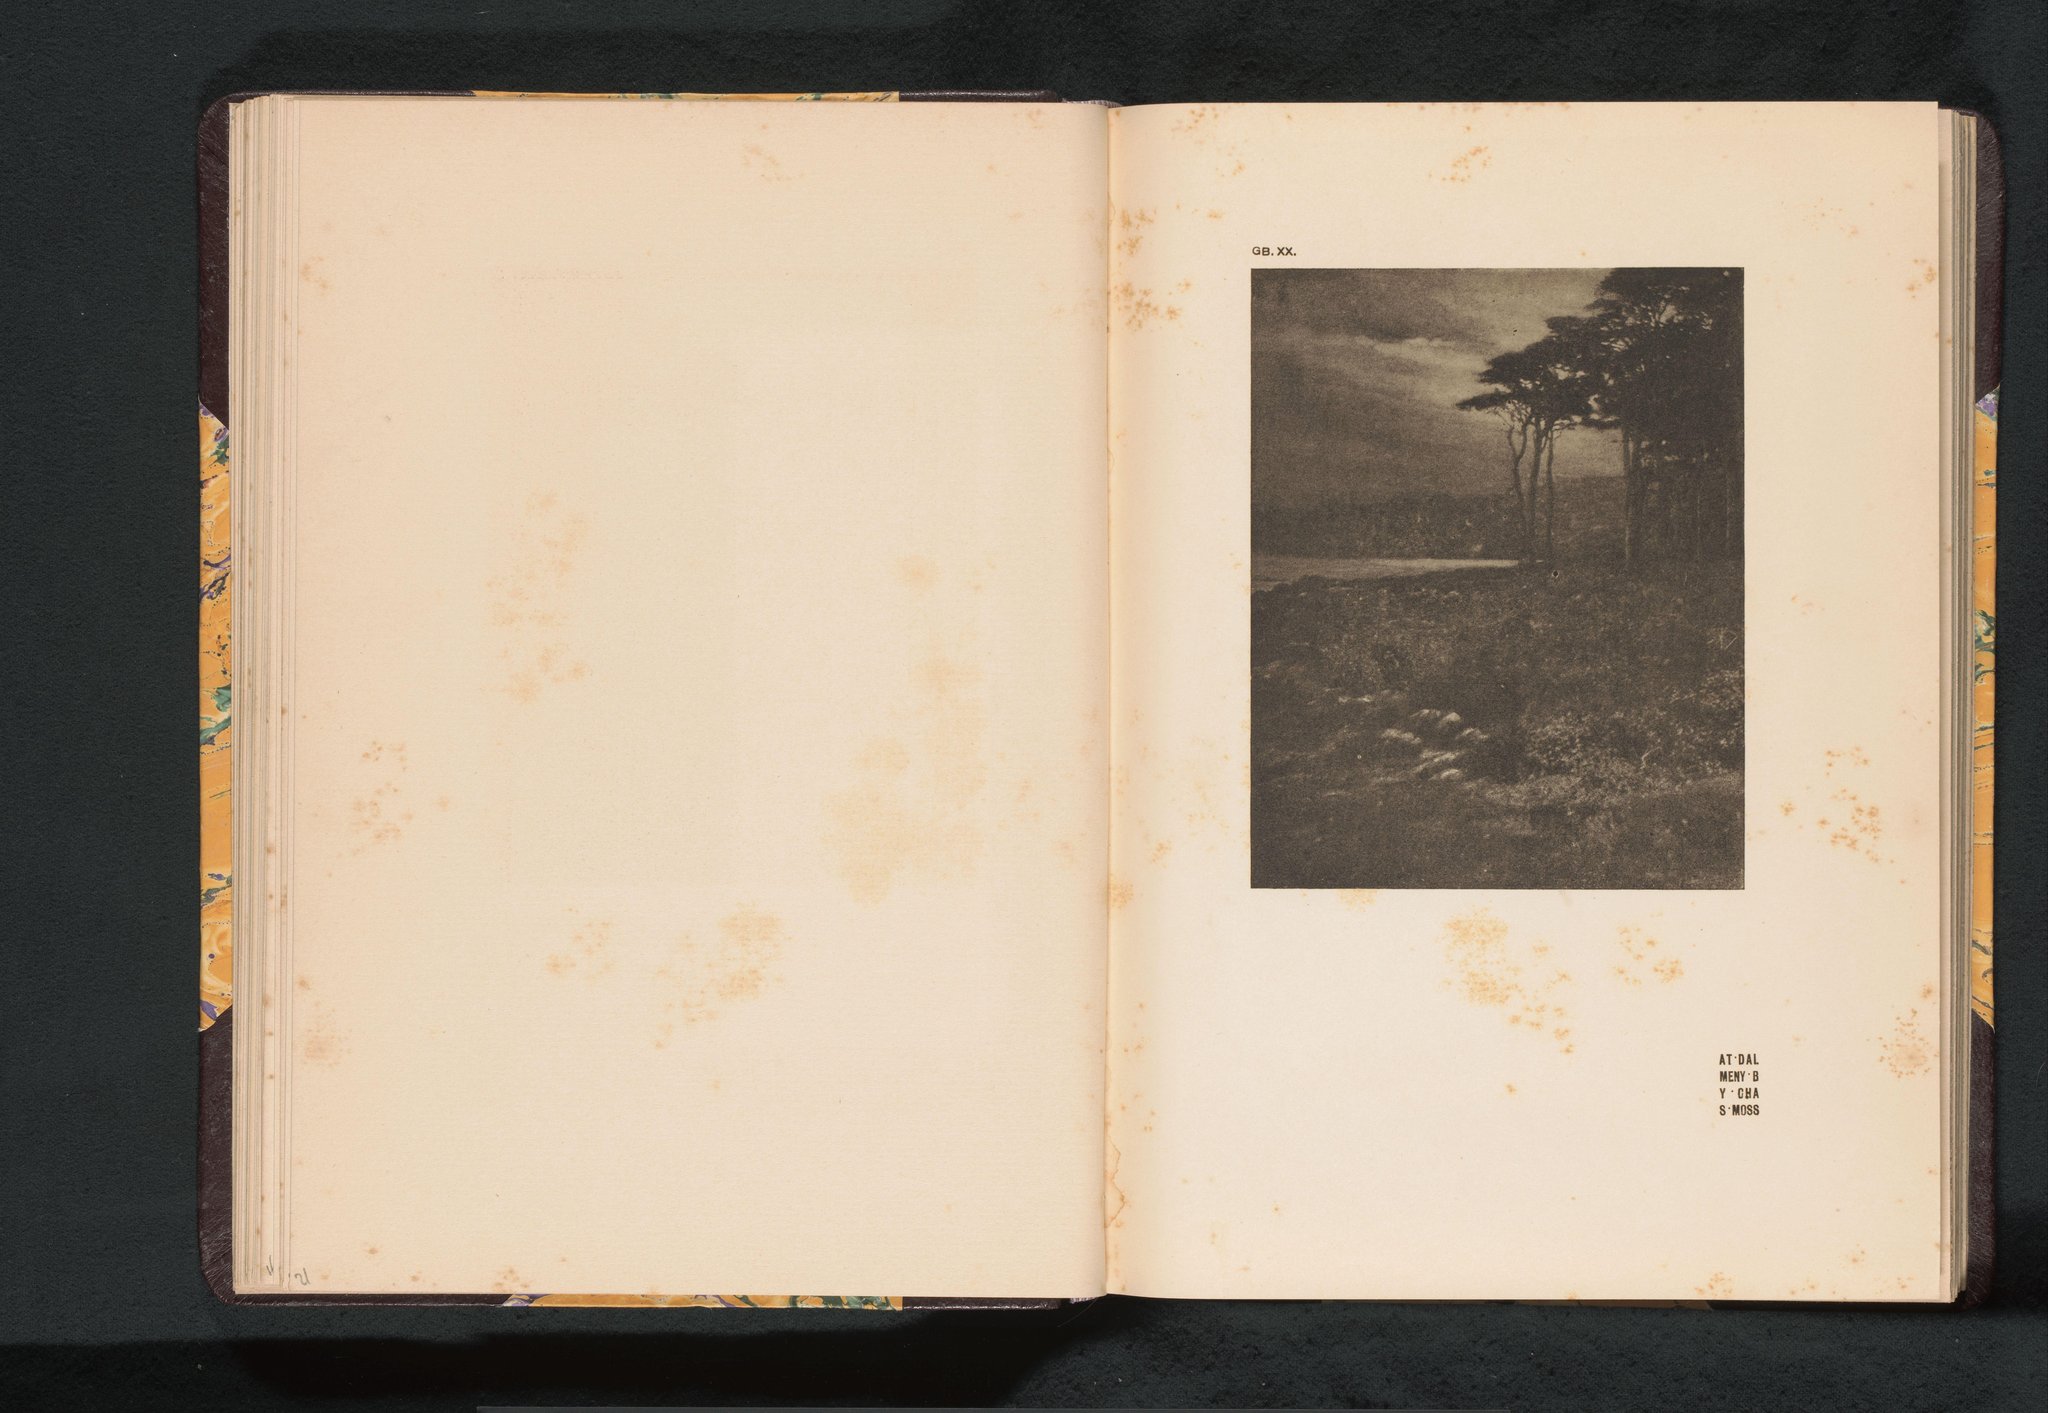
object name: page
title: Landschap te Dalmeny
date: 1900-1905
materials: paper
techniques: autotype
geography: dalmeny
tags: landscapes in the temperate zone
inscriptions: inscription: ‘At Dalmeny by Chas. Moss’, inscription: ‘GB. XX.’